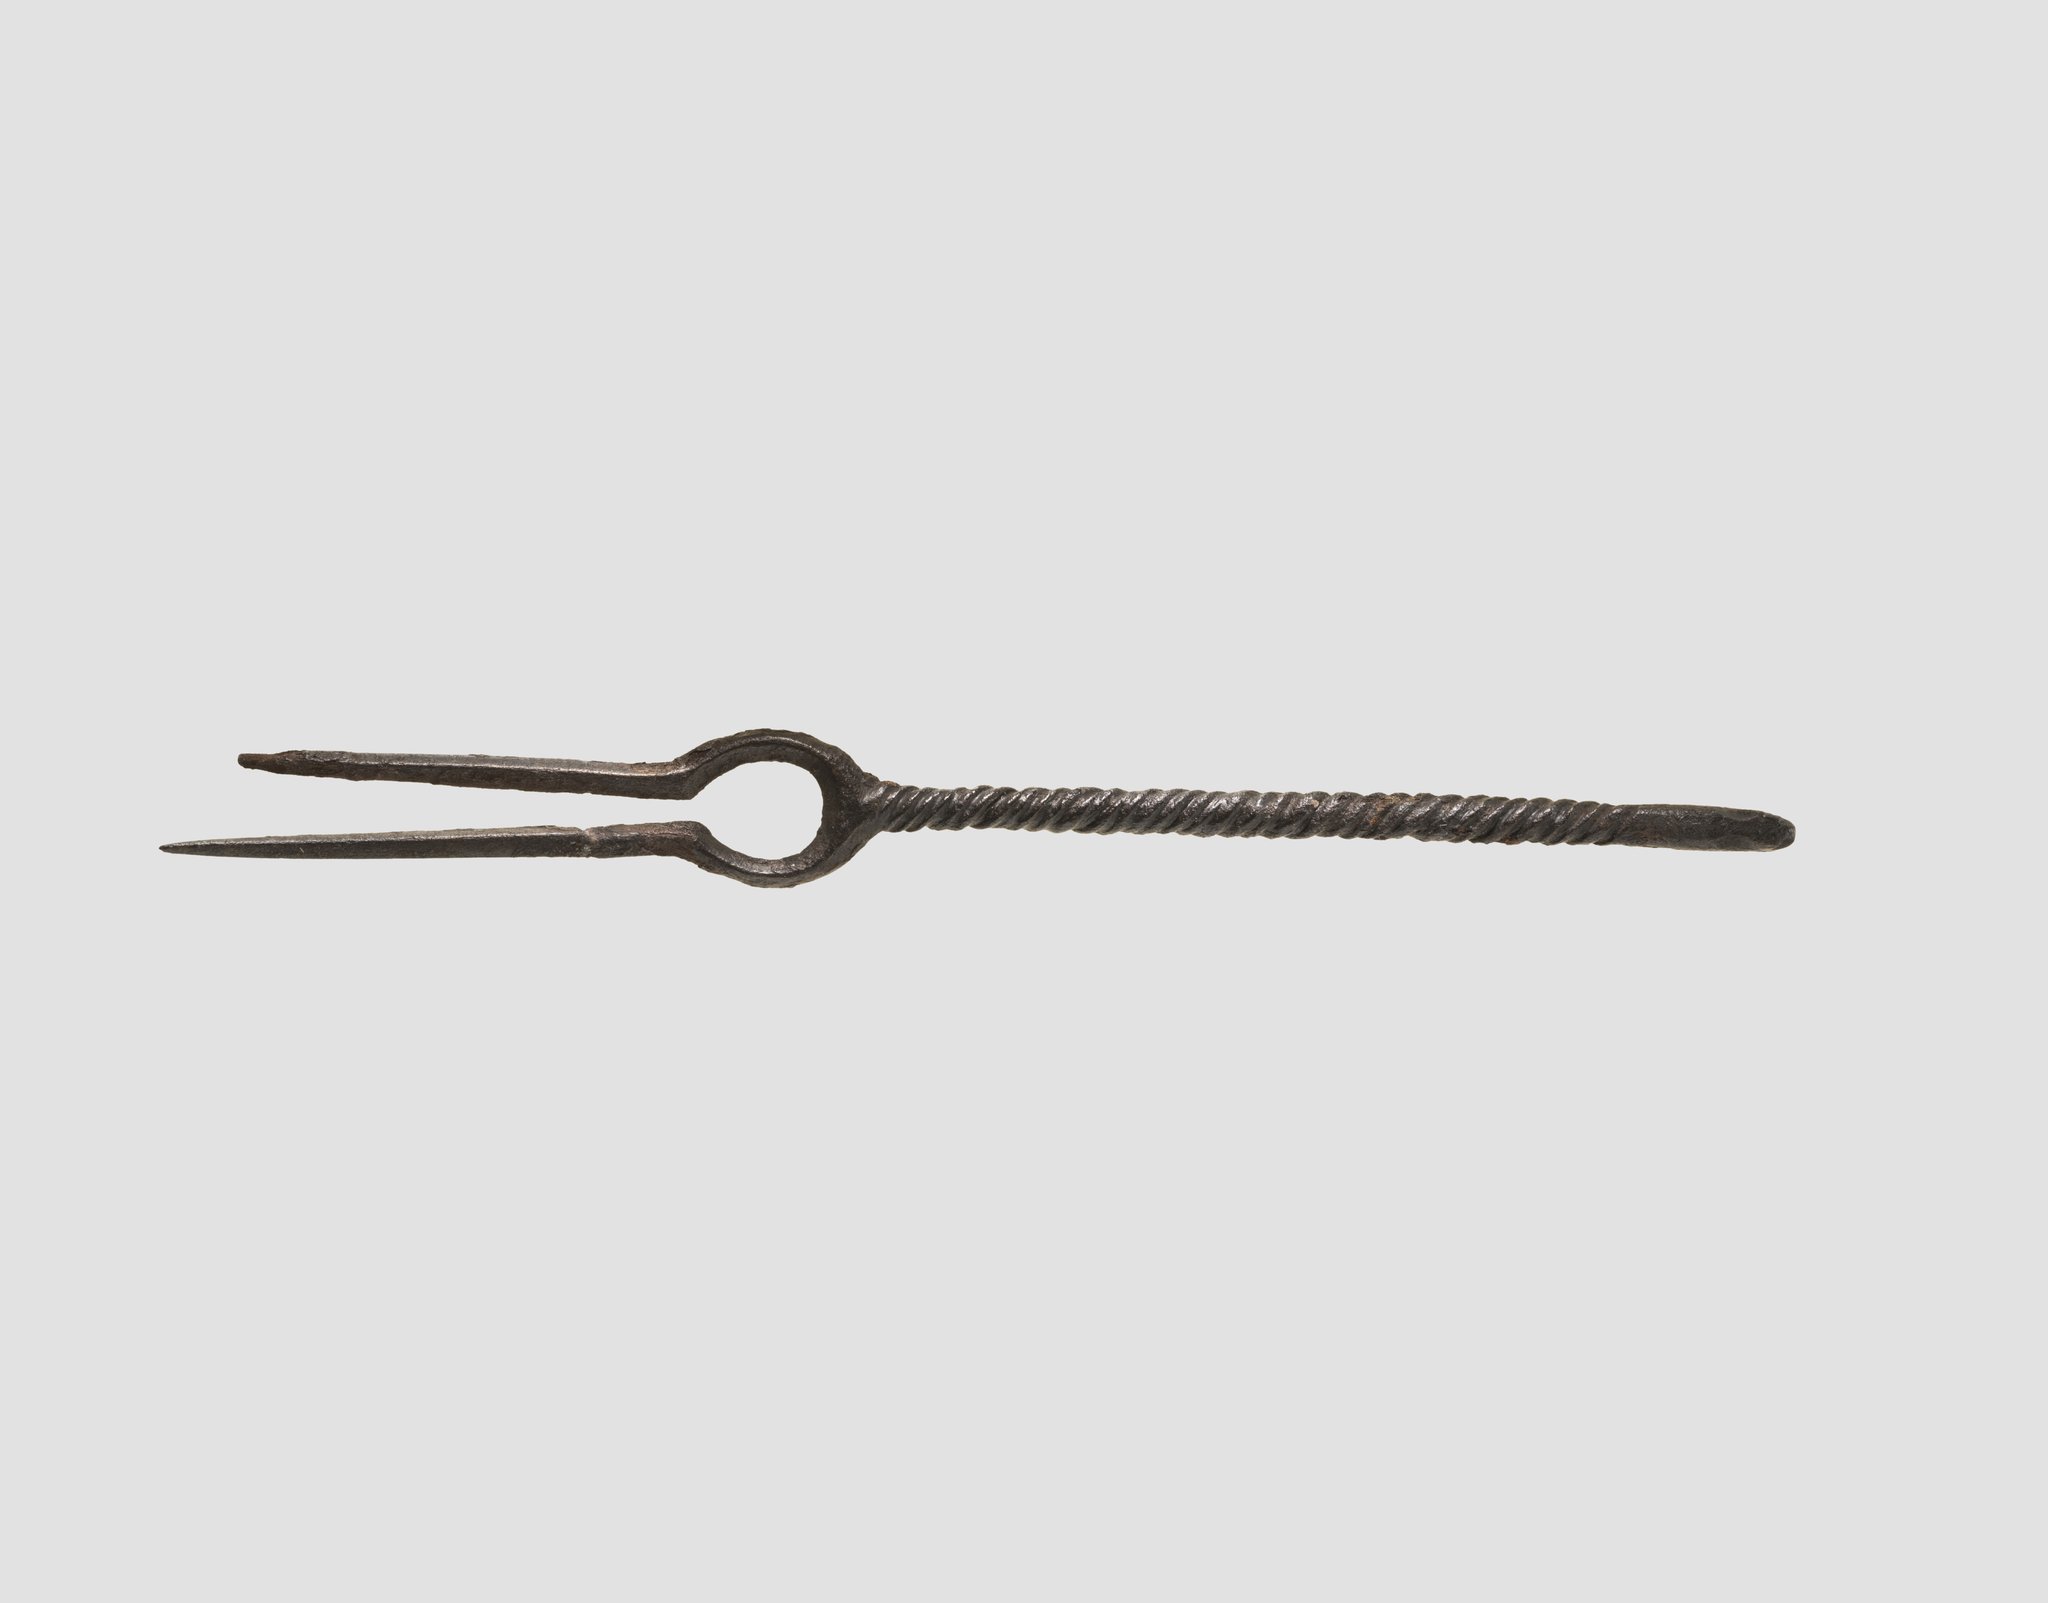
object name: fork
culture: sasanian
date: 501-700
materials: bronze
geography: iran